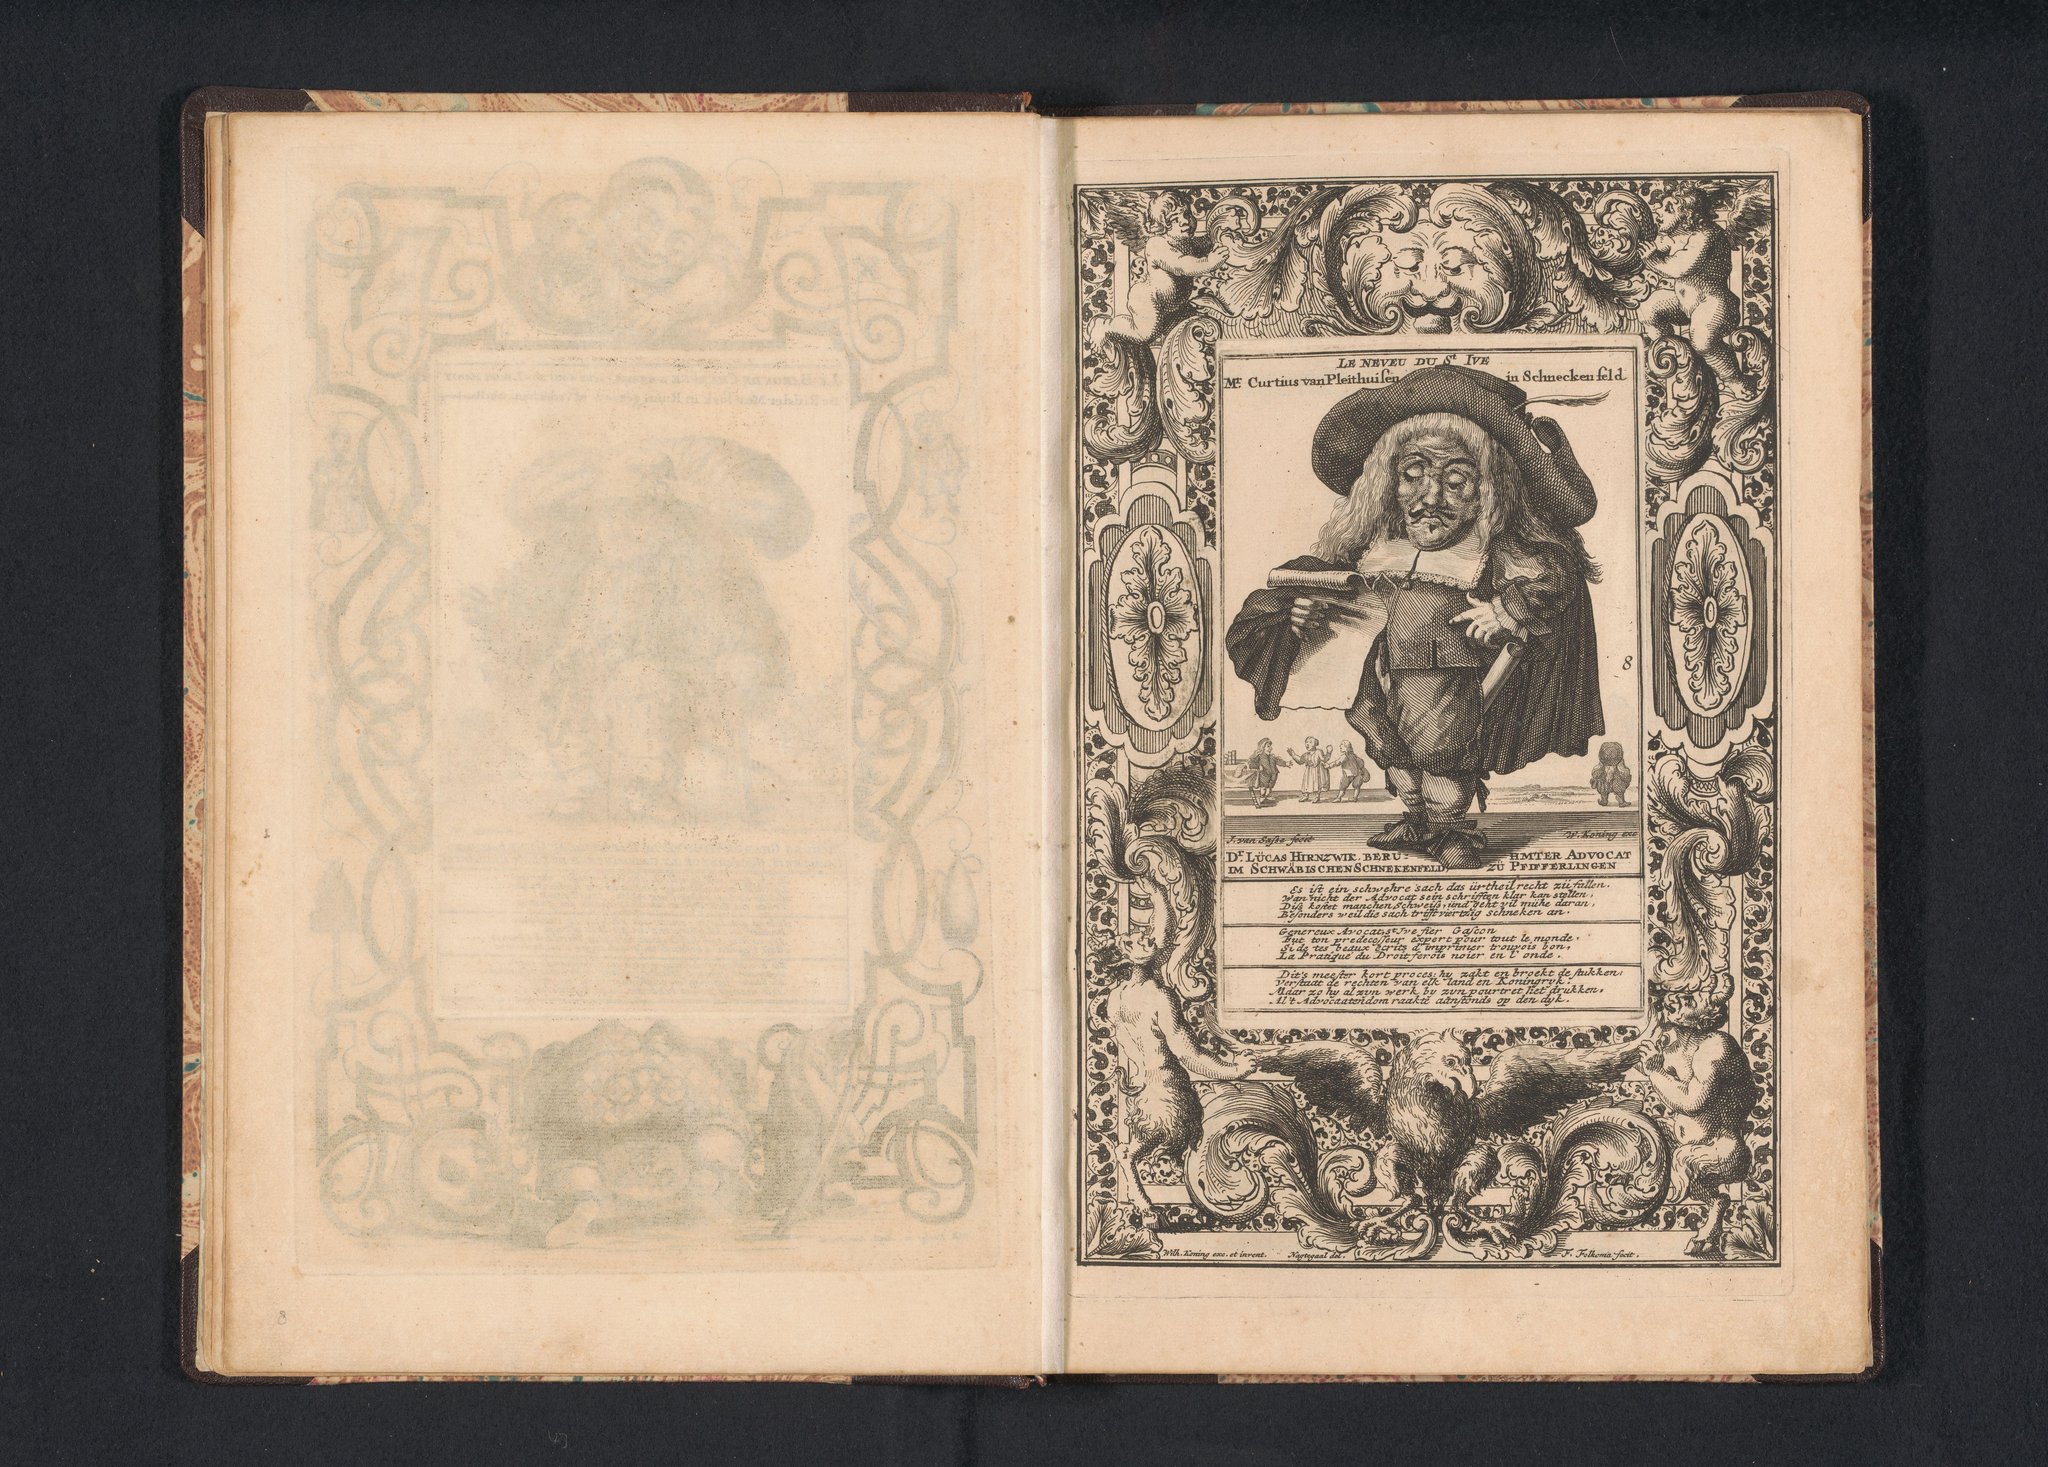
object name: caricature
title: De dwerg Mr. Curtius van Pleithuisen als een advocaat, 1716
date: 1716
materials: paper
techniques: etching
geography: northern netherlands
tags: caricatures (human types), little people, lawyer, attorney at law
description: De kleine mens Mr. Curtius van Pleithuisen als een advocaat die een document bestudeert. In het onderschrift verzen in het Duits, Frans en Nederlands. Afdruk binnen een decoratieve omlijsting gedrukt van een aparte plaat met saters, engelen en een adelaar. Genummerd rechts midden: 8. Onderdeel van de Nederlandse gebonden uitgave uit 1716 van een serie karikaturen van kleine mensen, bekend als Het Dwergentooneel, gekopieerd naar een ouder Duits voorbeeld.